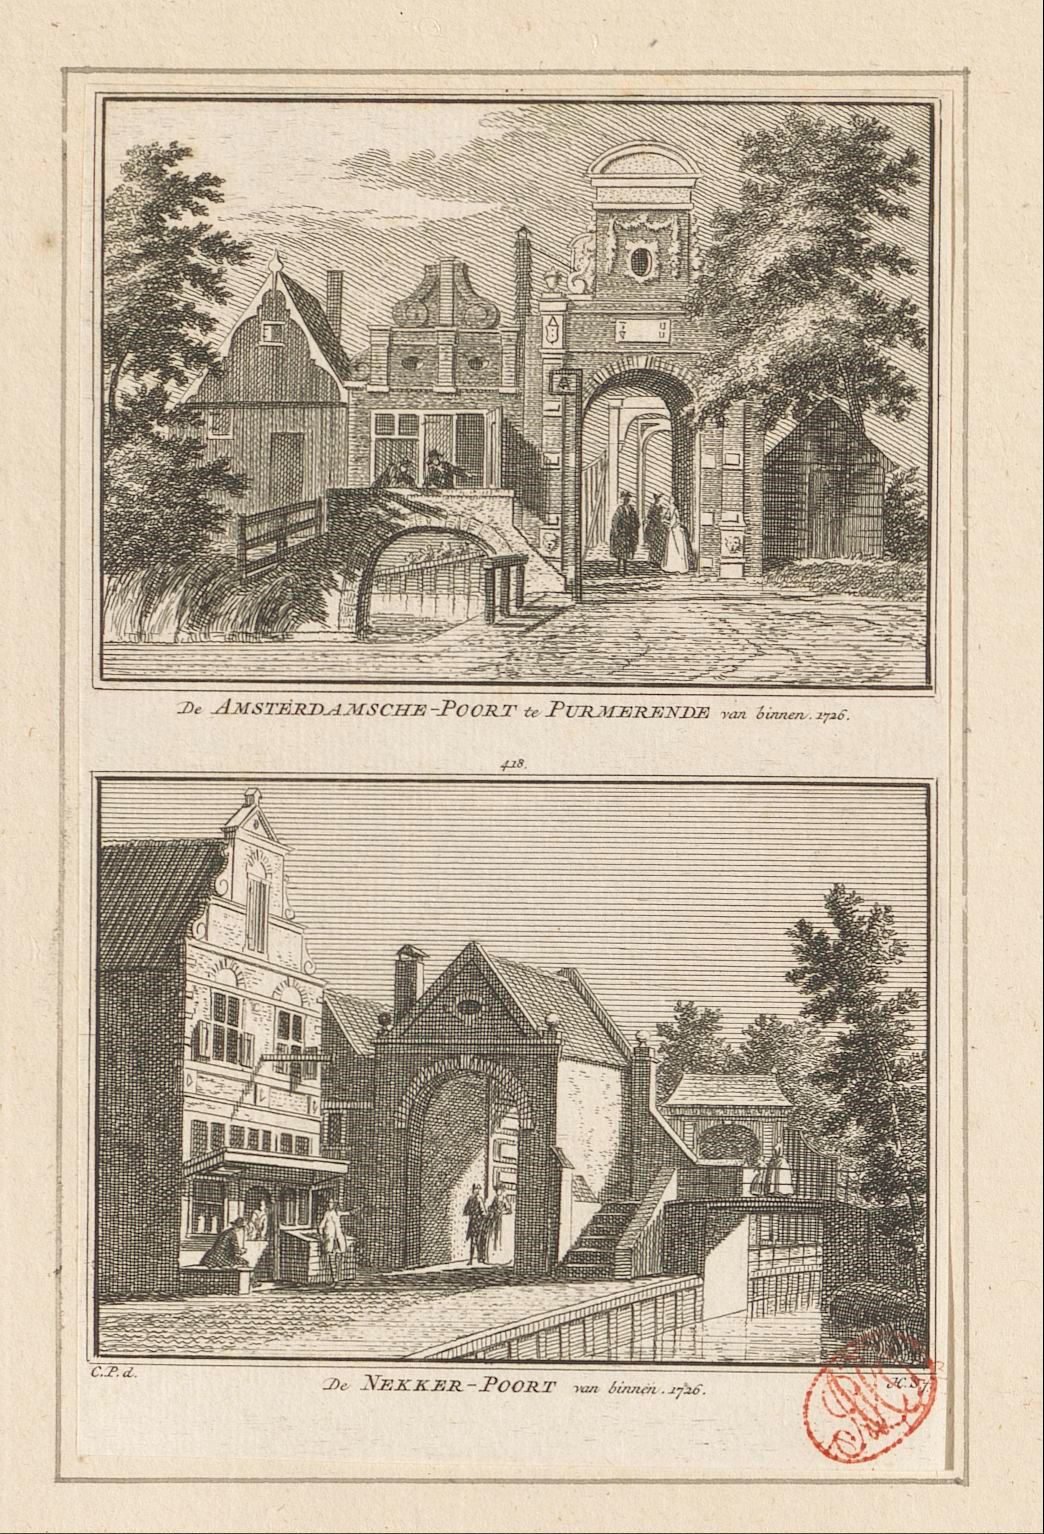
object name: book illustration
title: De Nekker-poort van binnen. 1726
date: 1757-1792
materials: paper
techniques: engraving, etching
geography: haarlem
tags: bridge, city-gate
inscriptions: collector's mark: Lugt 195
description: Prent ook gebruikt in: Het verheerlykt Nederland of kabinet van hedendaagsche gezigten van steden, dorpen (…). 9 delen. Amsterdam: Isaak Tirion en weduwe Isaak Tirion, 1745-1774, dl. 6 (Isaak Tirion, 1757), ill. 417 en 418. Of in: Nederlandsche tafereelen; of eene keurige verzameling van negen honderd fraaije gezigten van steden, dorpen, sloten, oudheden (….). 9 delen. Amsterdam: Jan de Groot, 1792, dl. 6, ill. 417 en 418. Uit welke druk het huidige exemplaar precies komt is niet na te gaan.